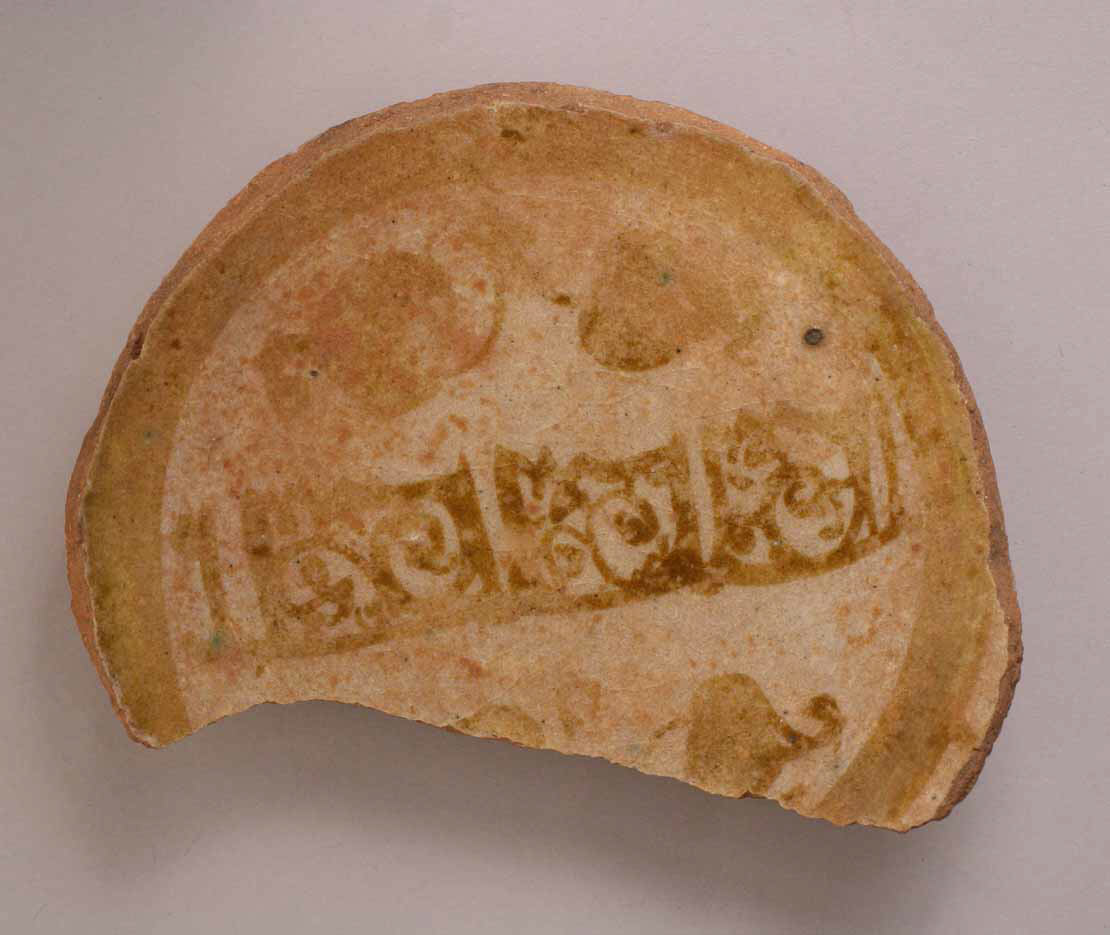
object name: ceramic fragment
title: Fragment of a Bowl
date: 1001-1200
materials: earthenware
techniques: luster painting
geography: egypt